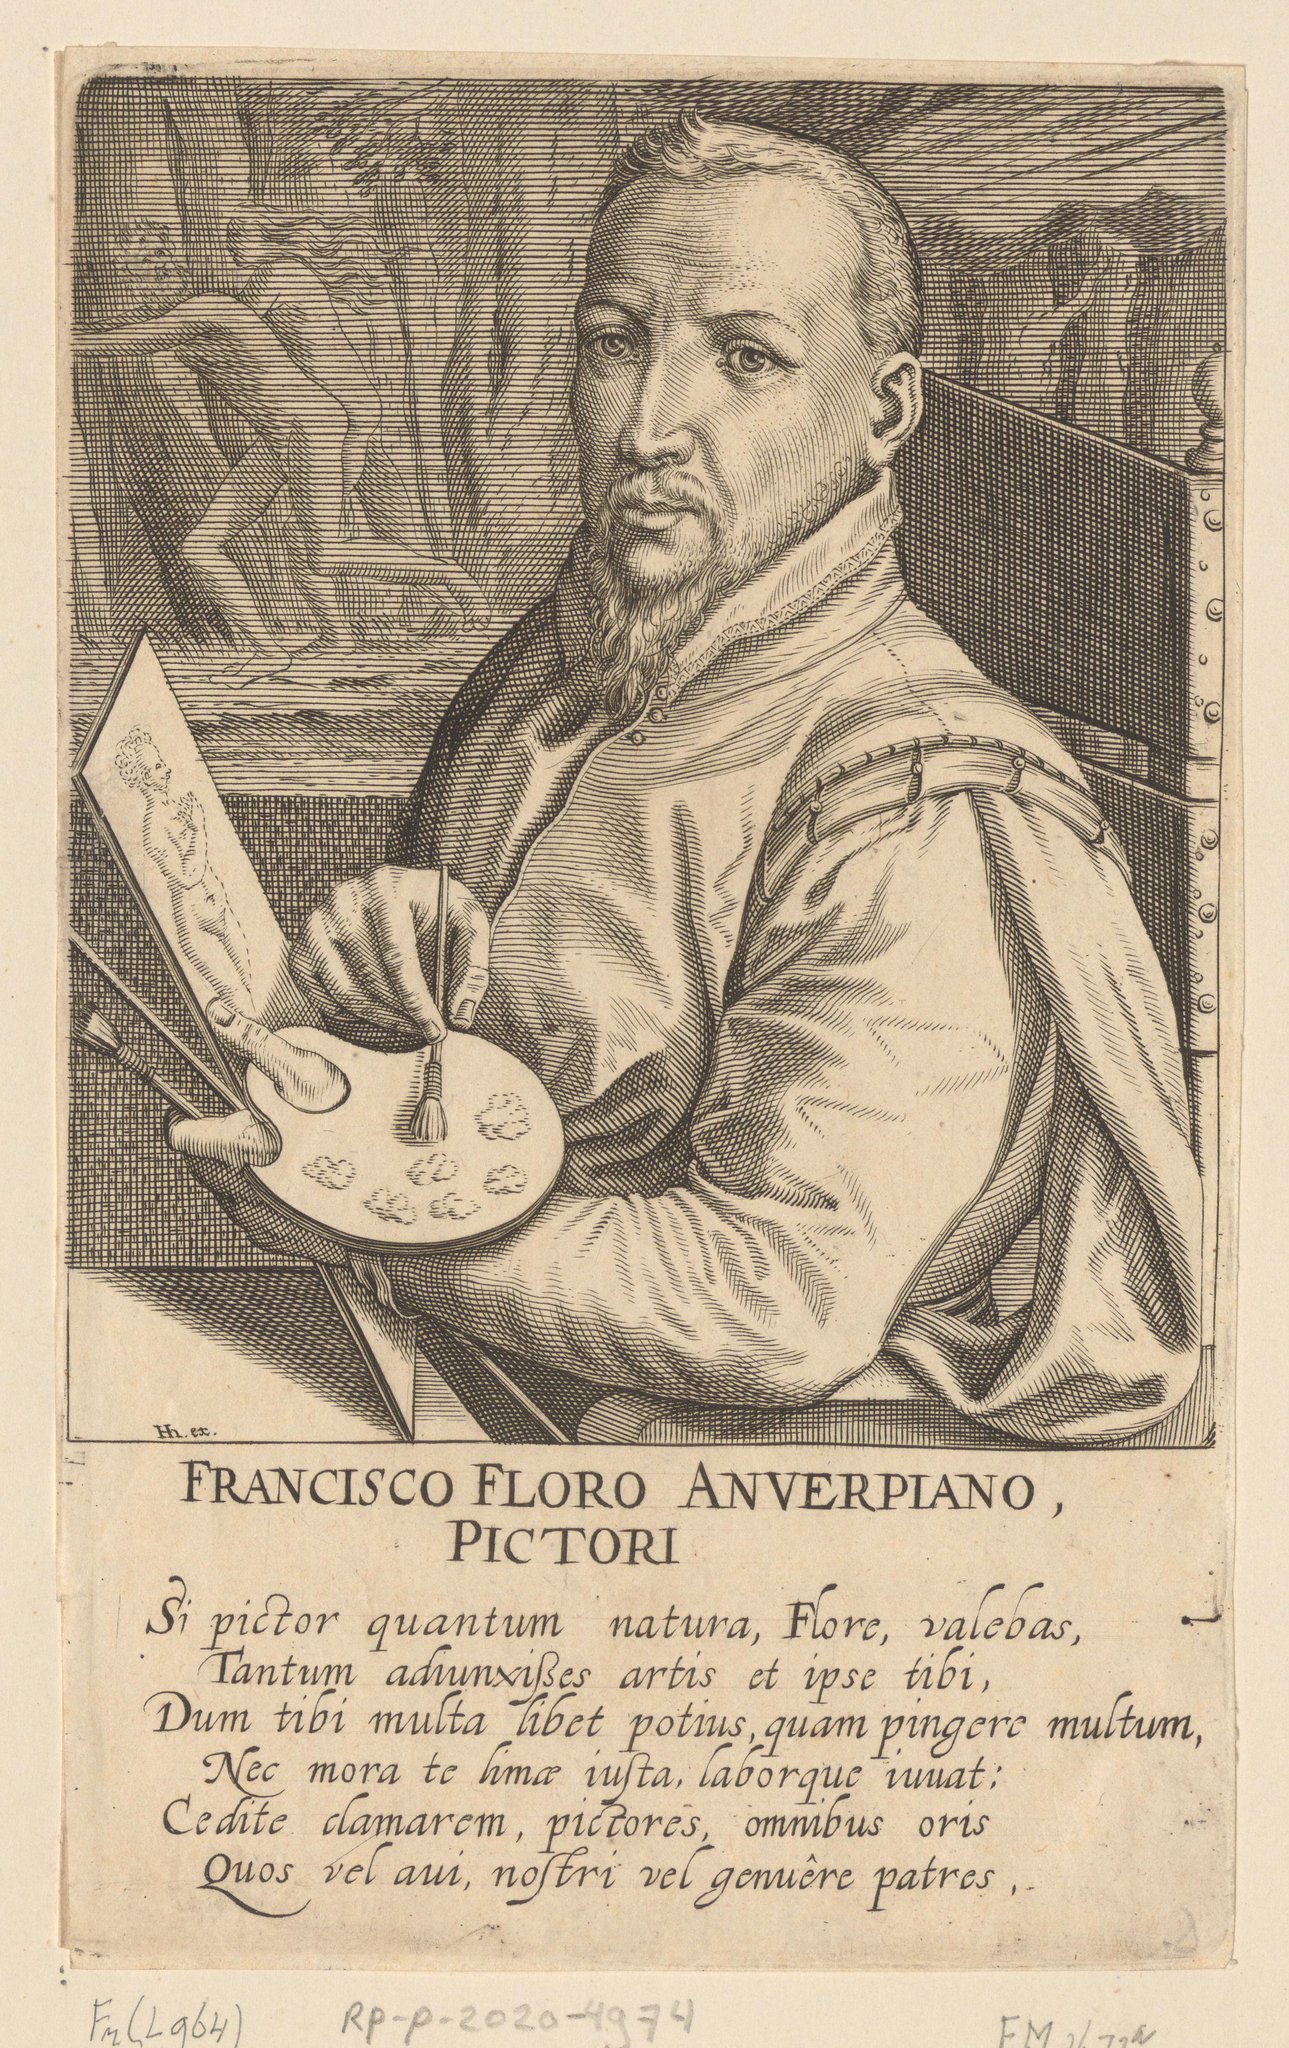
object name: print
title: Portret van Frans Floris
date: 1610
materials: paper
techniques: engraving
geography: the hague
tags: antwerp, print maker, draughtsman, frans floris (i), historical persons, expulsion of adam and eve from paradise (genesis 3:22-24), portrait, self-portrait of painter, palette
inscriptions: collector's mark: Lugt 964, inscription: ‘April: 89’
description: Prent uit deel 1 van de serie Pictorum Aliquot Celebrium Praecipuae Germaniae Inferioris Effigies (1610). Serie van 72 kunstenaarsportretten vervaardigd door Hendrick Hondius I, Simon Frisius, Andries Jacobsz. Stock en Robert de Baudous. Prent ook gebruikt in tweede druk uit 1618.